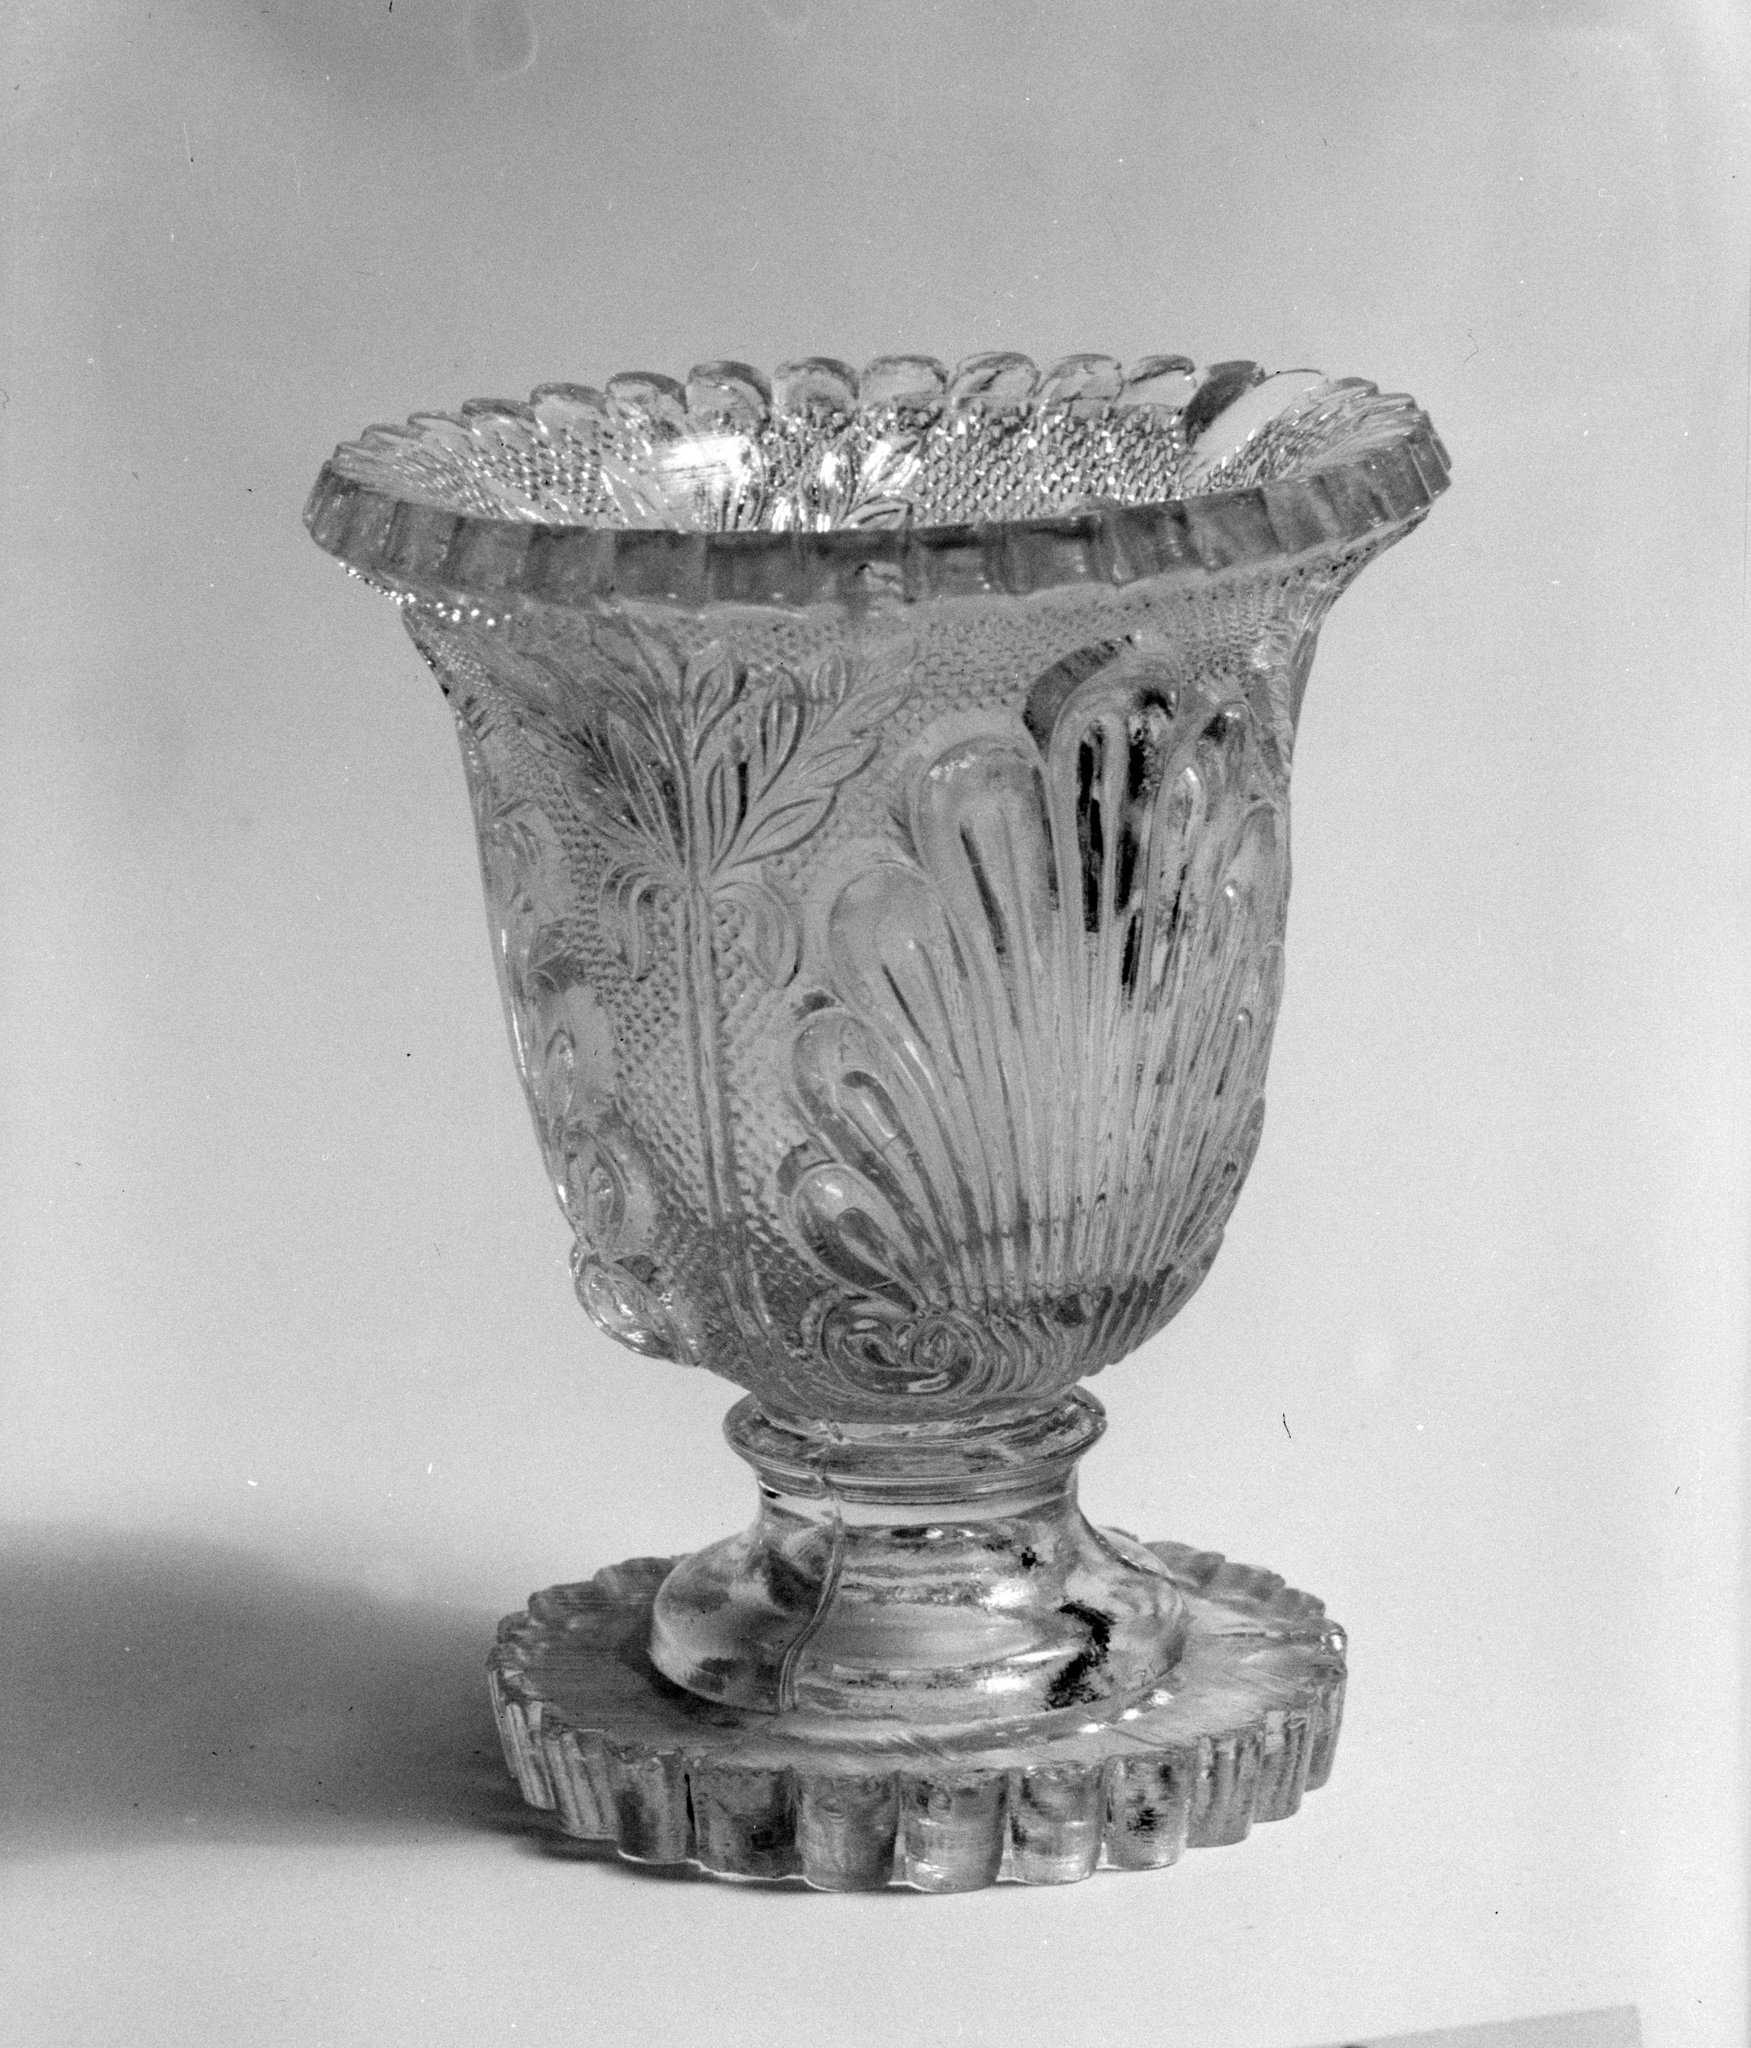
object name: egg cup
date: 1830-1850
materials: glass